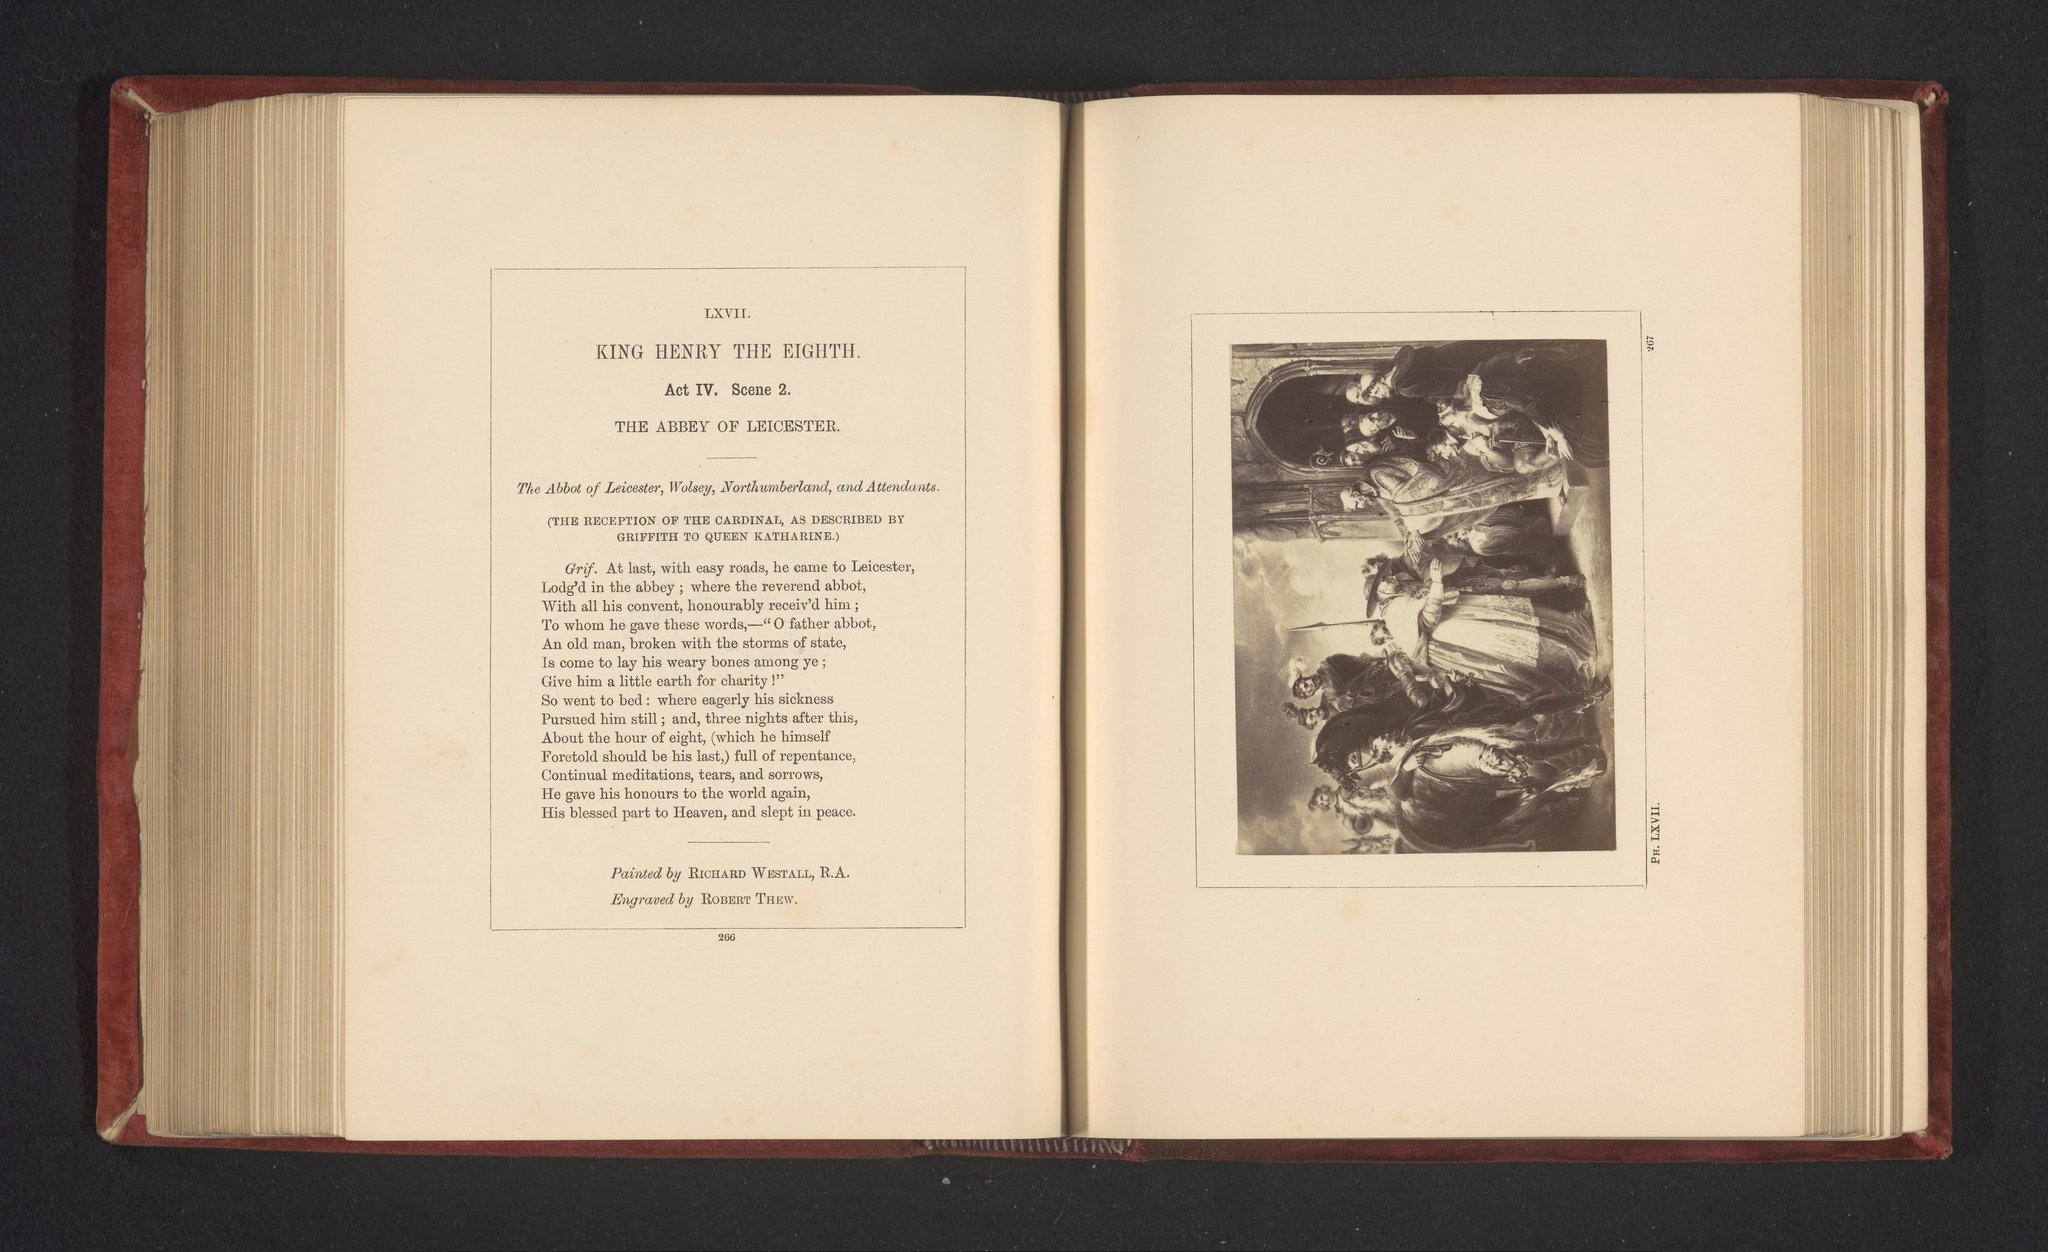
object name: page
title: Fotoreproductie van een prent naar een schilderij door Richard Westall, voorstellend een scene uit Hendrik VIII door William Shakespeare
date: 1854-1864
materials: photographic support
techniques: albumen print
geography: london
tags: specific works of literature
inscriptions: number: ‘Ph. LXVII. 267’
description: Te zien is akte IV, scene 2 met een gezelschap voor de abdij van Leicester.